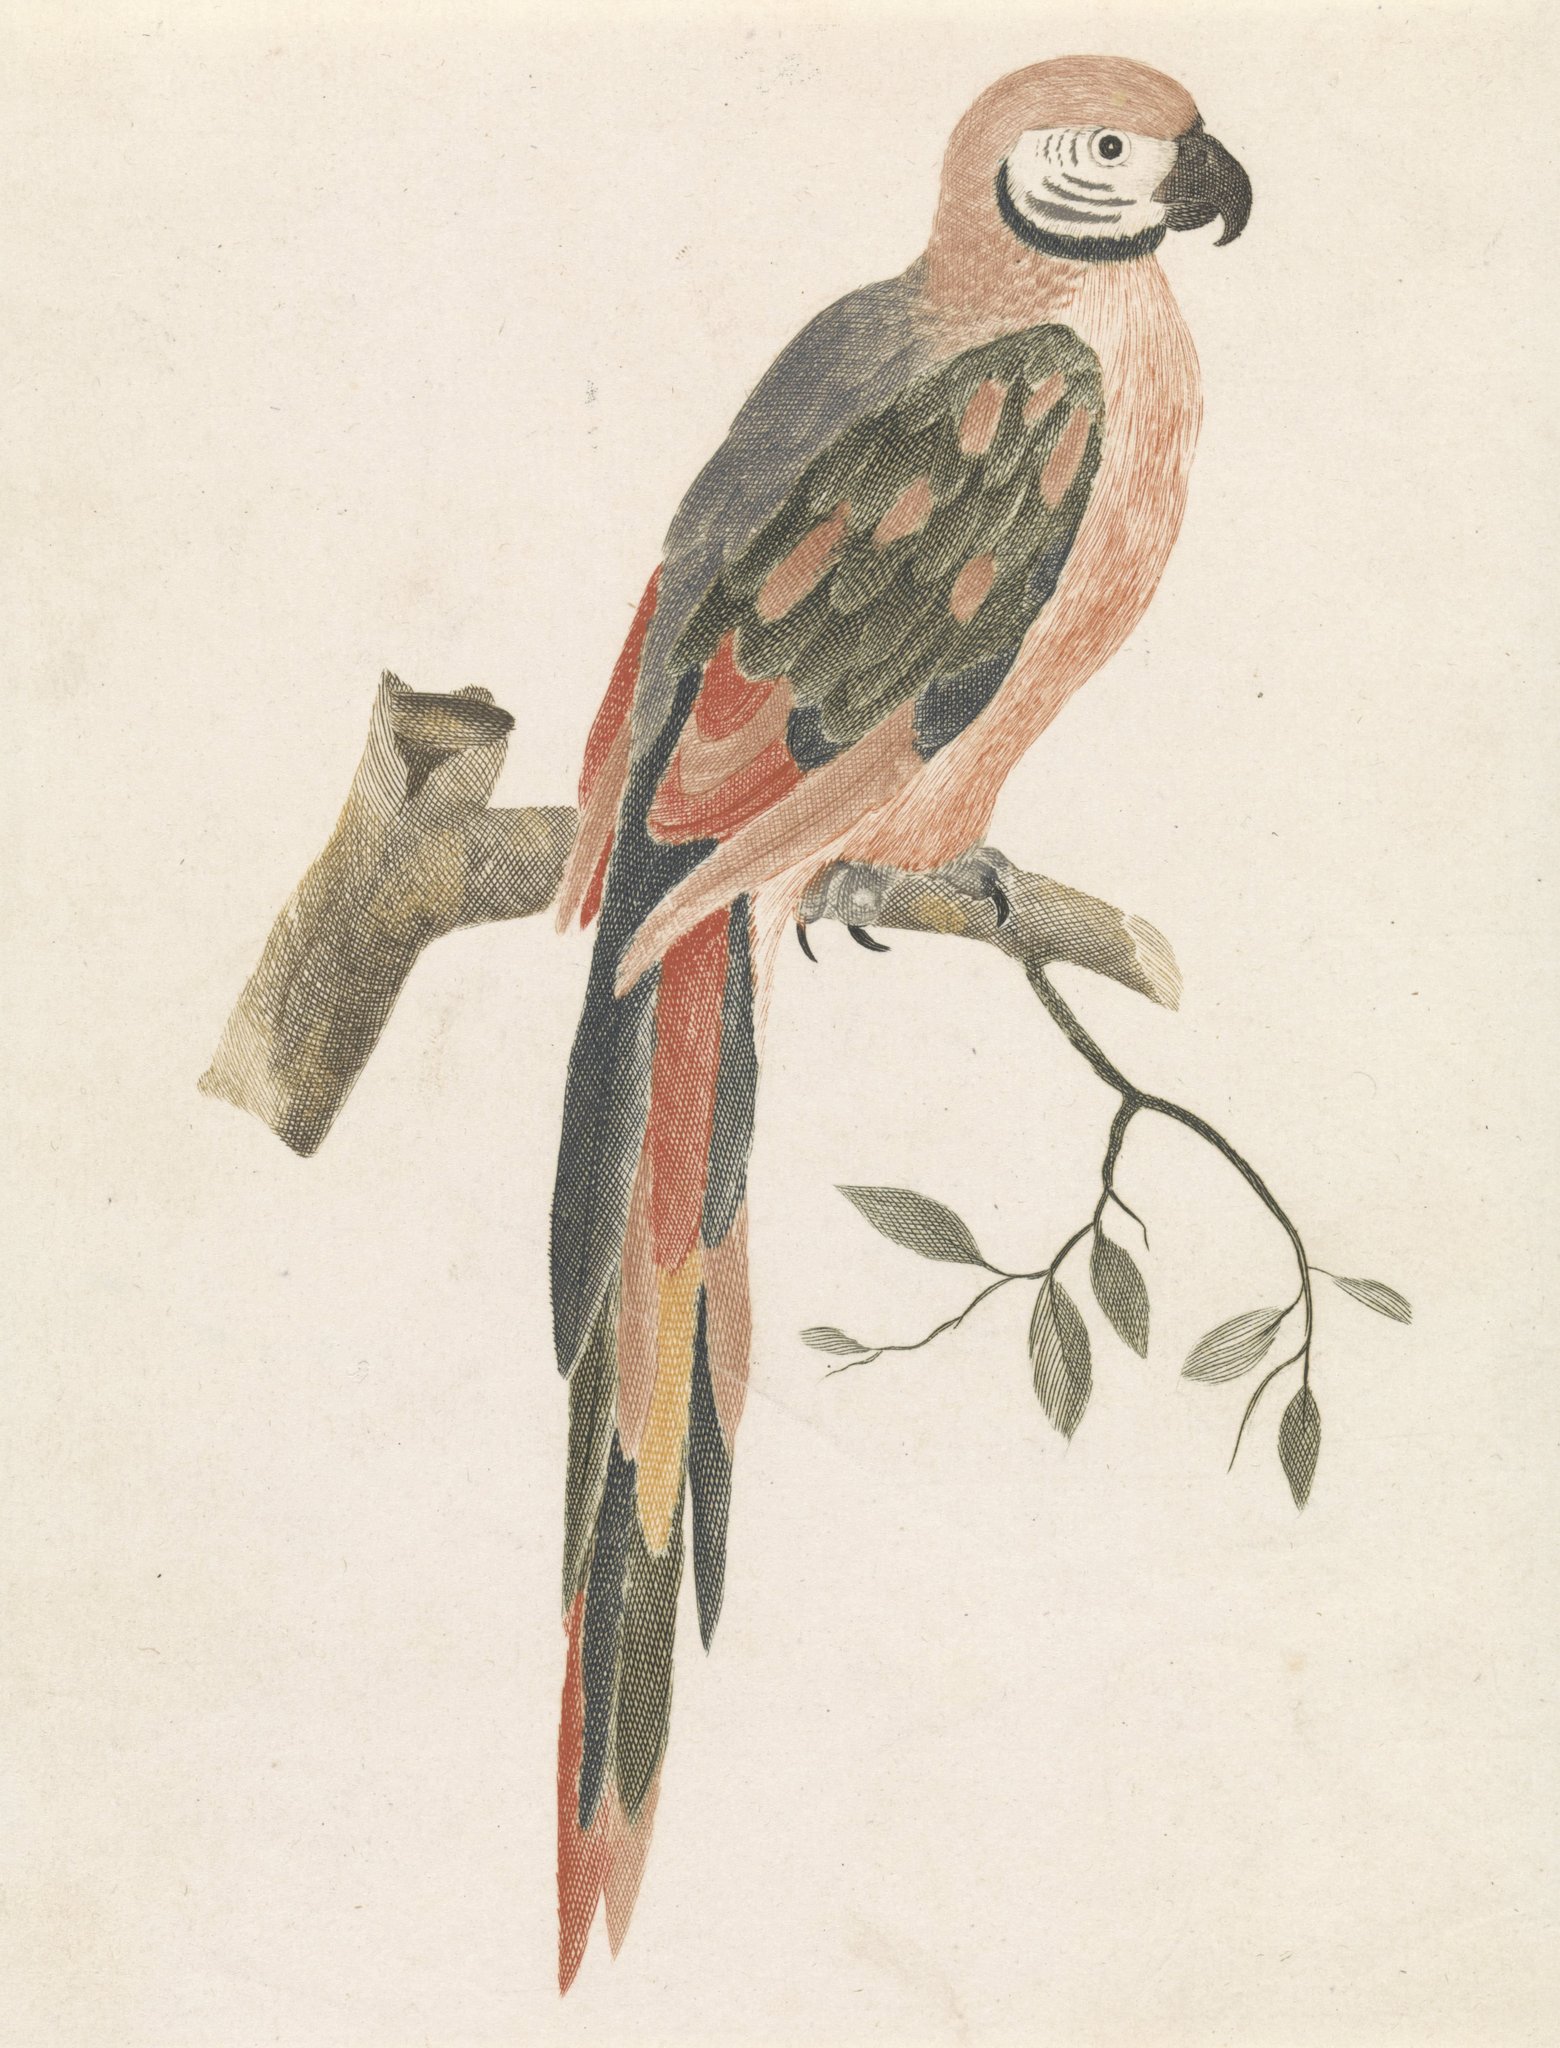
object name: print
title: Papegaai op een tak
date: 1688-1698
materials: paper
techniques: printing, engraving, lithography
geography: netherlands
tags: ornamental birds: parrot